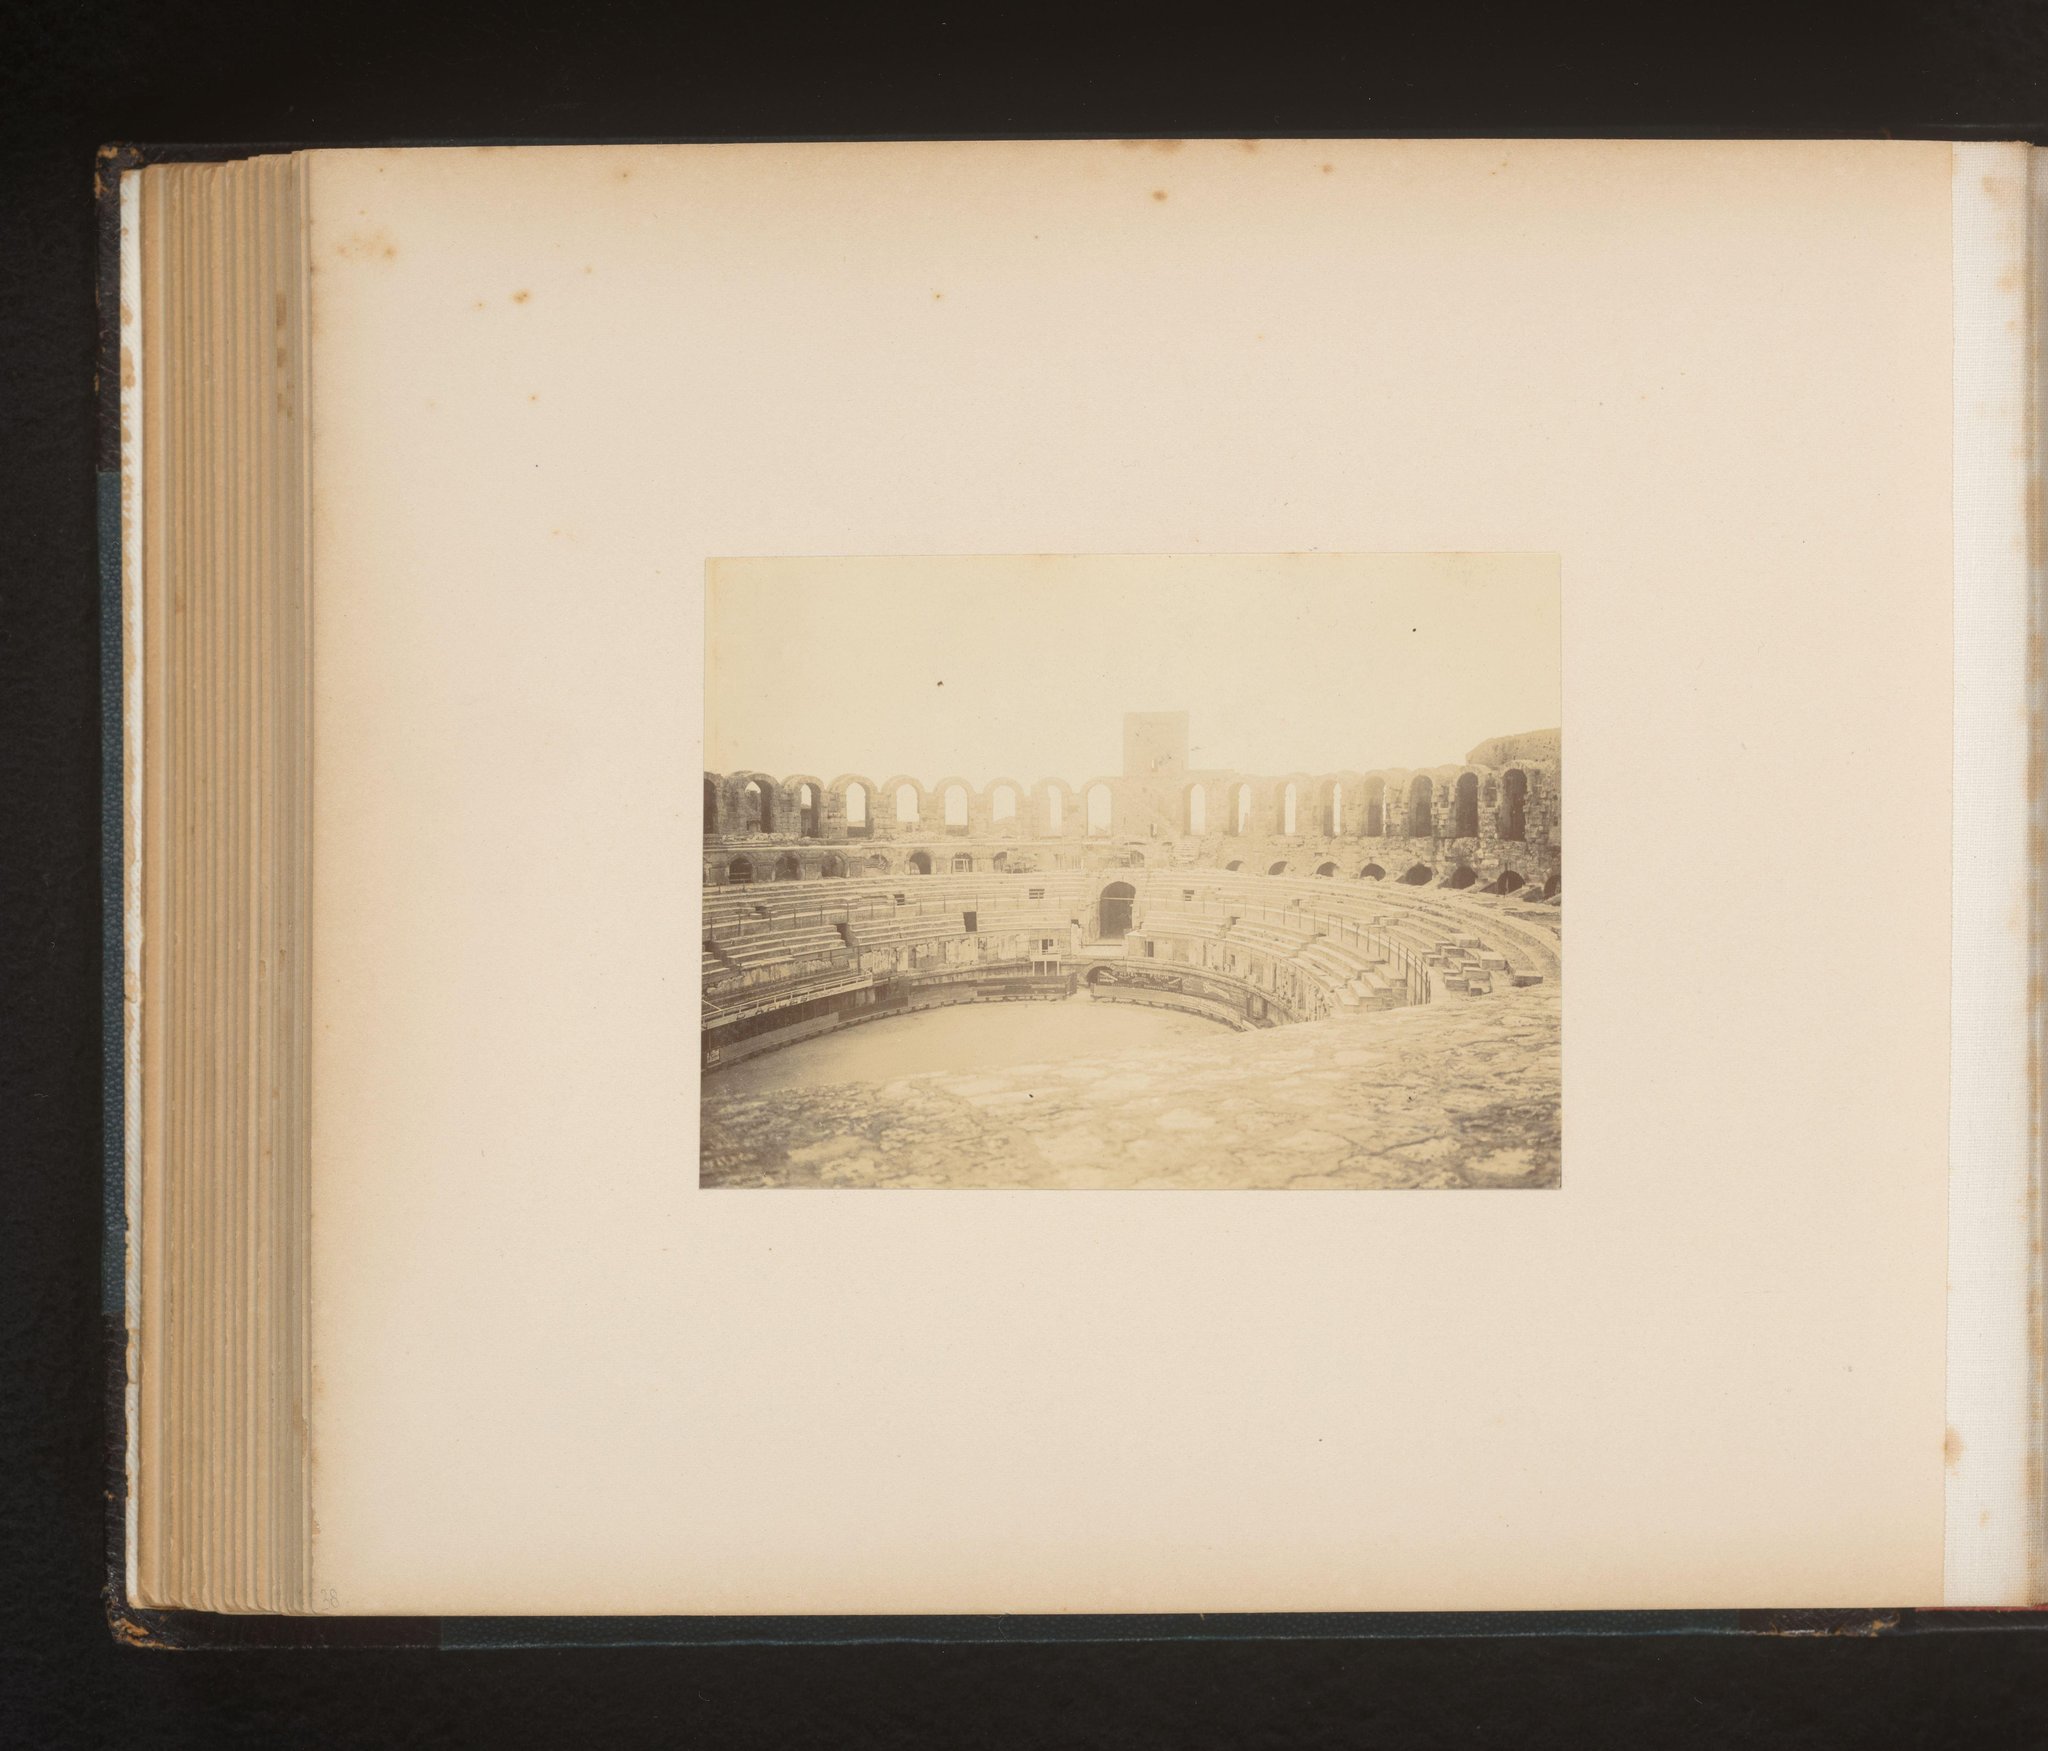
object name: photograph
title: Arena van het Amfitheater van Arles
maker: Anonymous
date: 1880-1920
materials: cardboard, photographic support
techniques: gelatin silver print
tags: amphitheatre